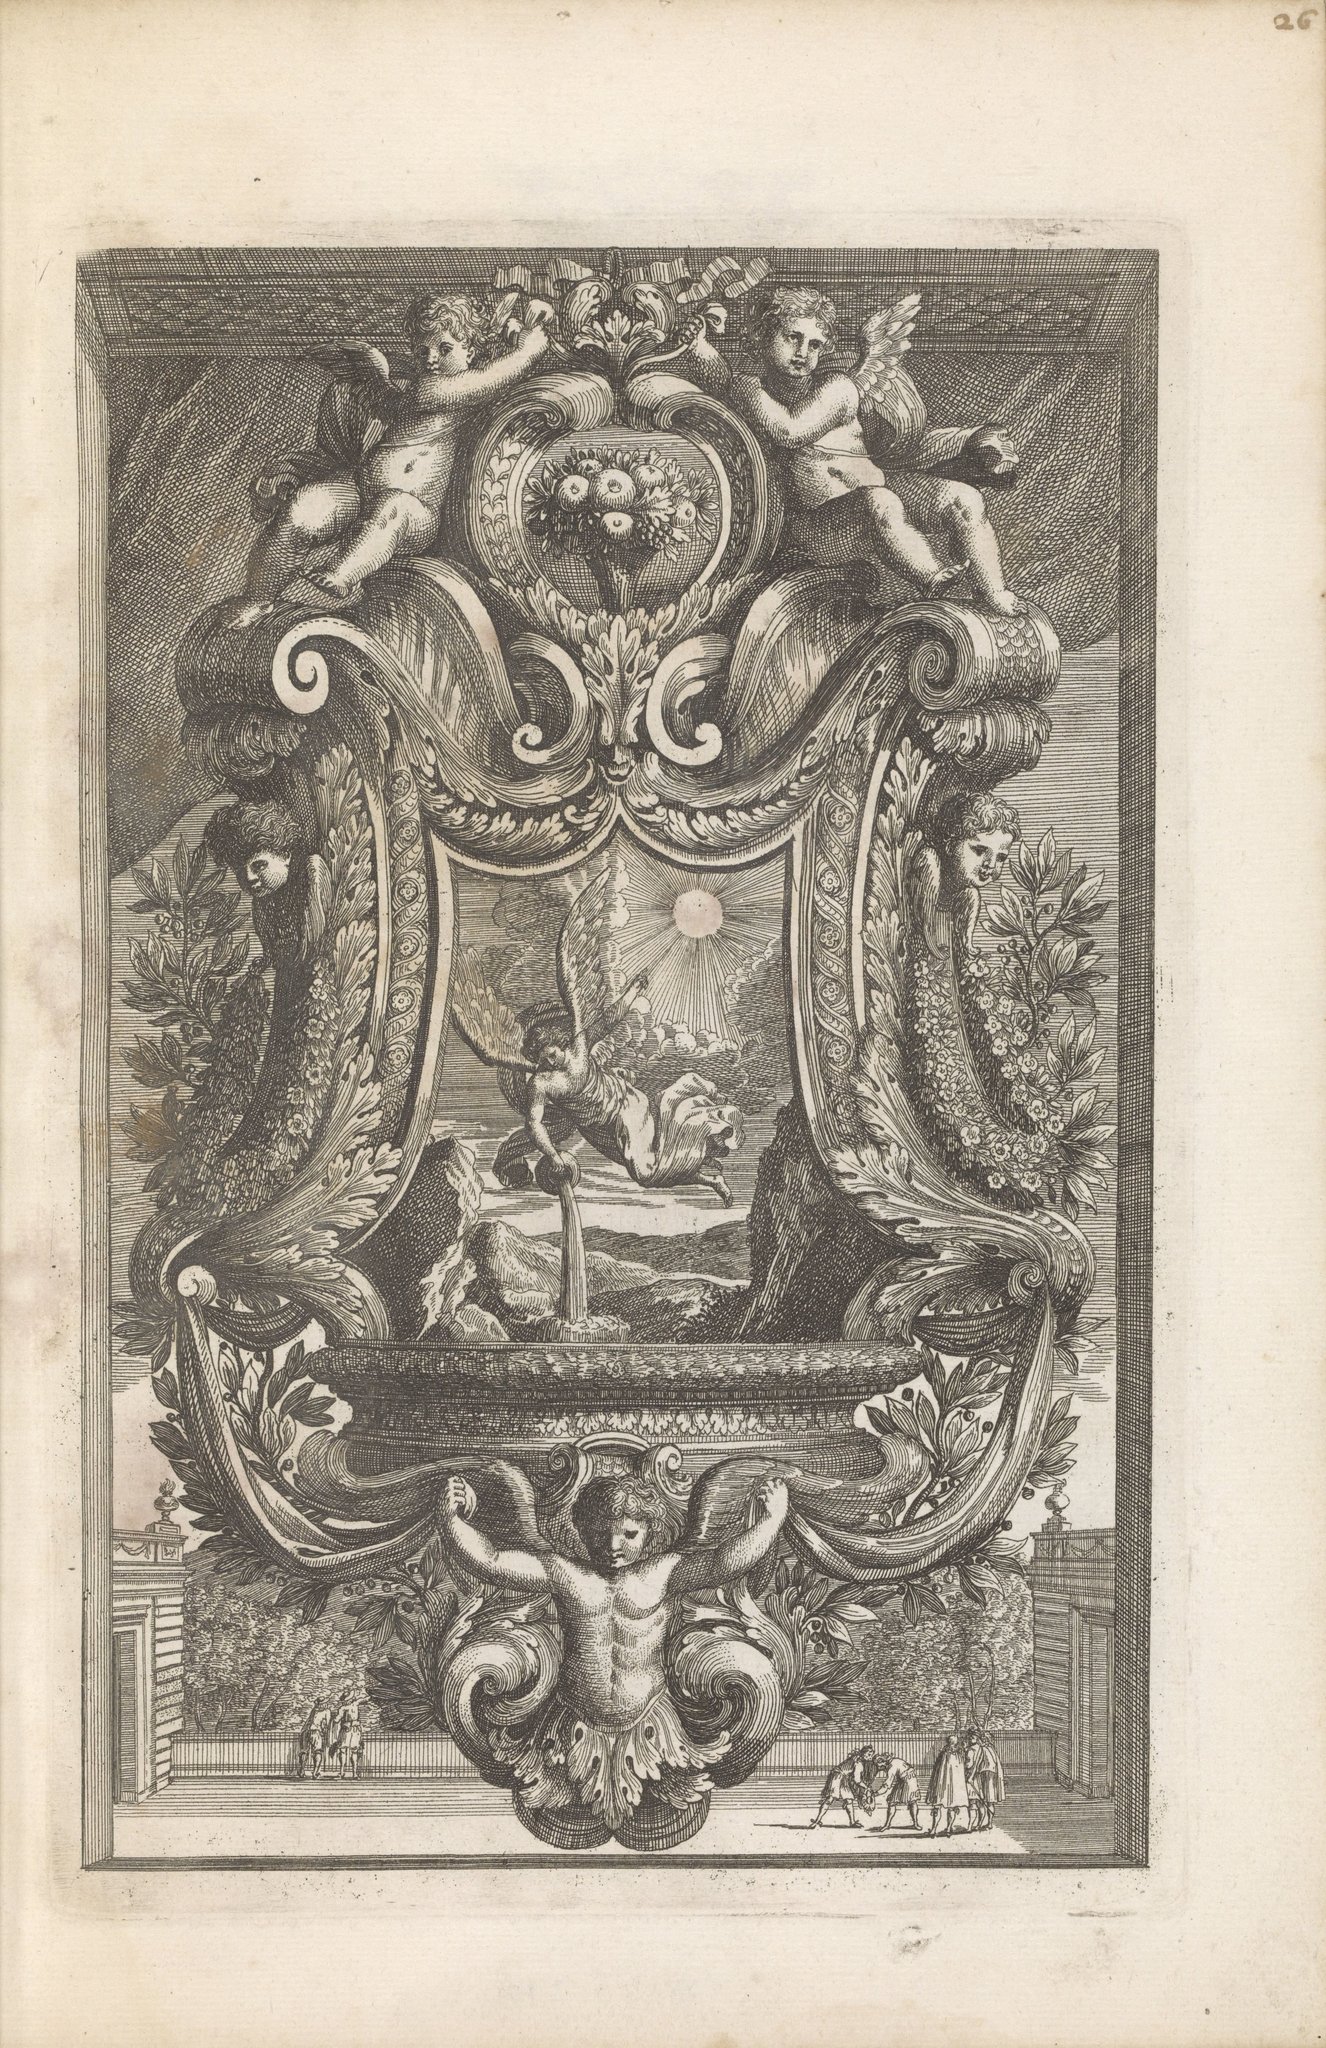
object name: ornament print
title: Varie inventioni di vasi da acqua benedetta fatti al moderno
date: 1677-1692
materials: paper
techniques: etching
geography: antwerp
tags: ornaments ~ art, holy water font, angels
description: Wijwaterbak met op de achterplaat een engel die water uit een kan giet. Uit serie van 6 bladen met kopieën naar de serie Inuentions pour faire des plaques ou des Aubenistiers seruans aux Orfeures van Jean Lepautre. Ontwerpen voor wijwaterbakken. Prent maakt deel uit van een album.